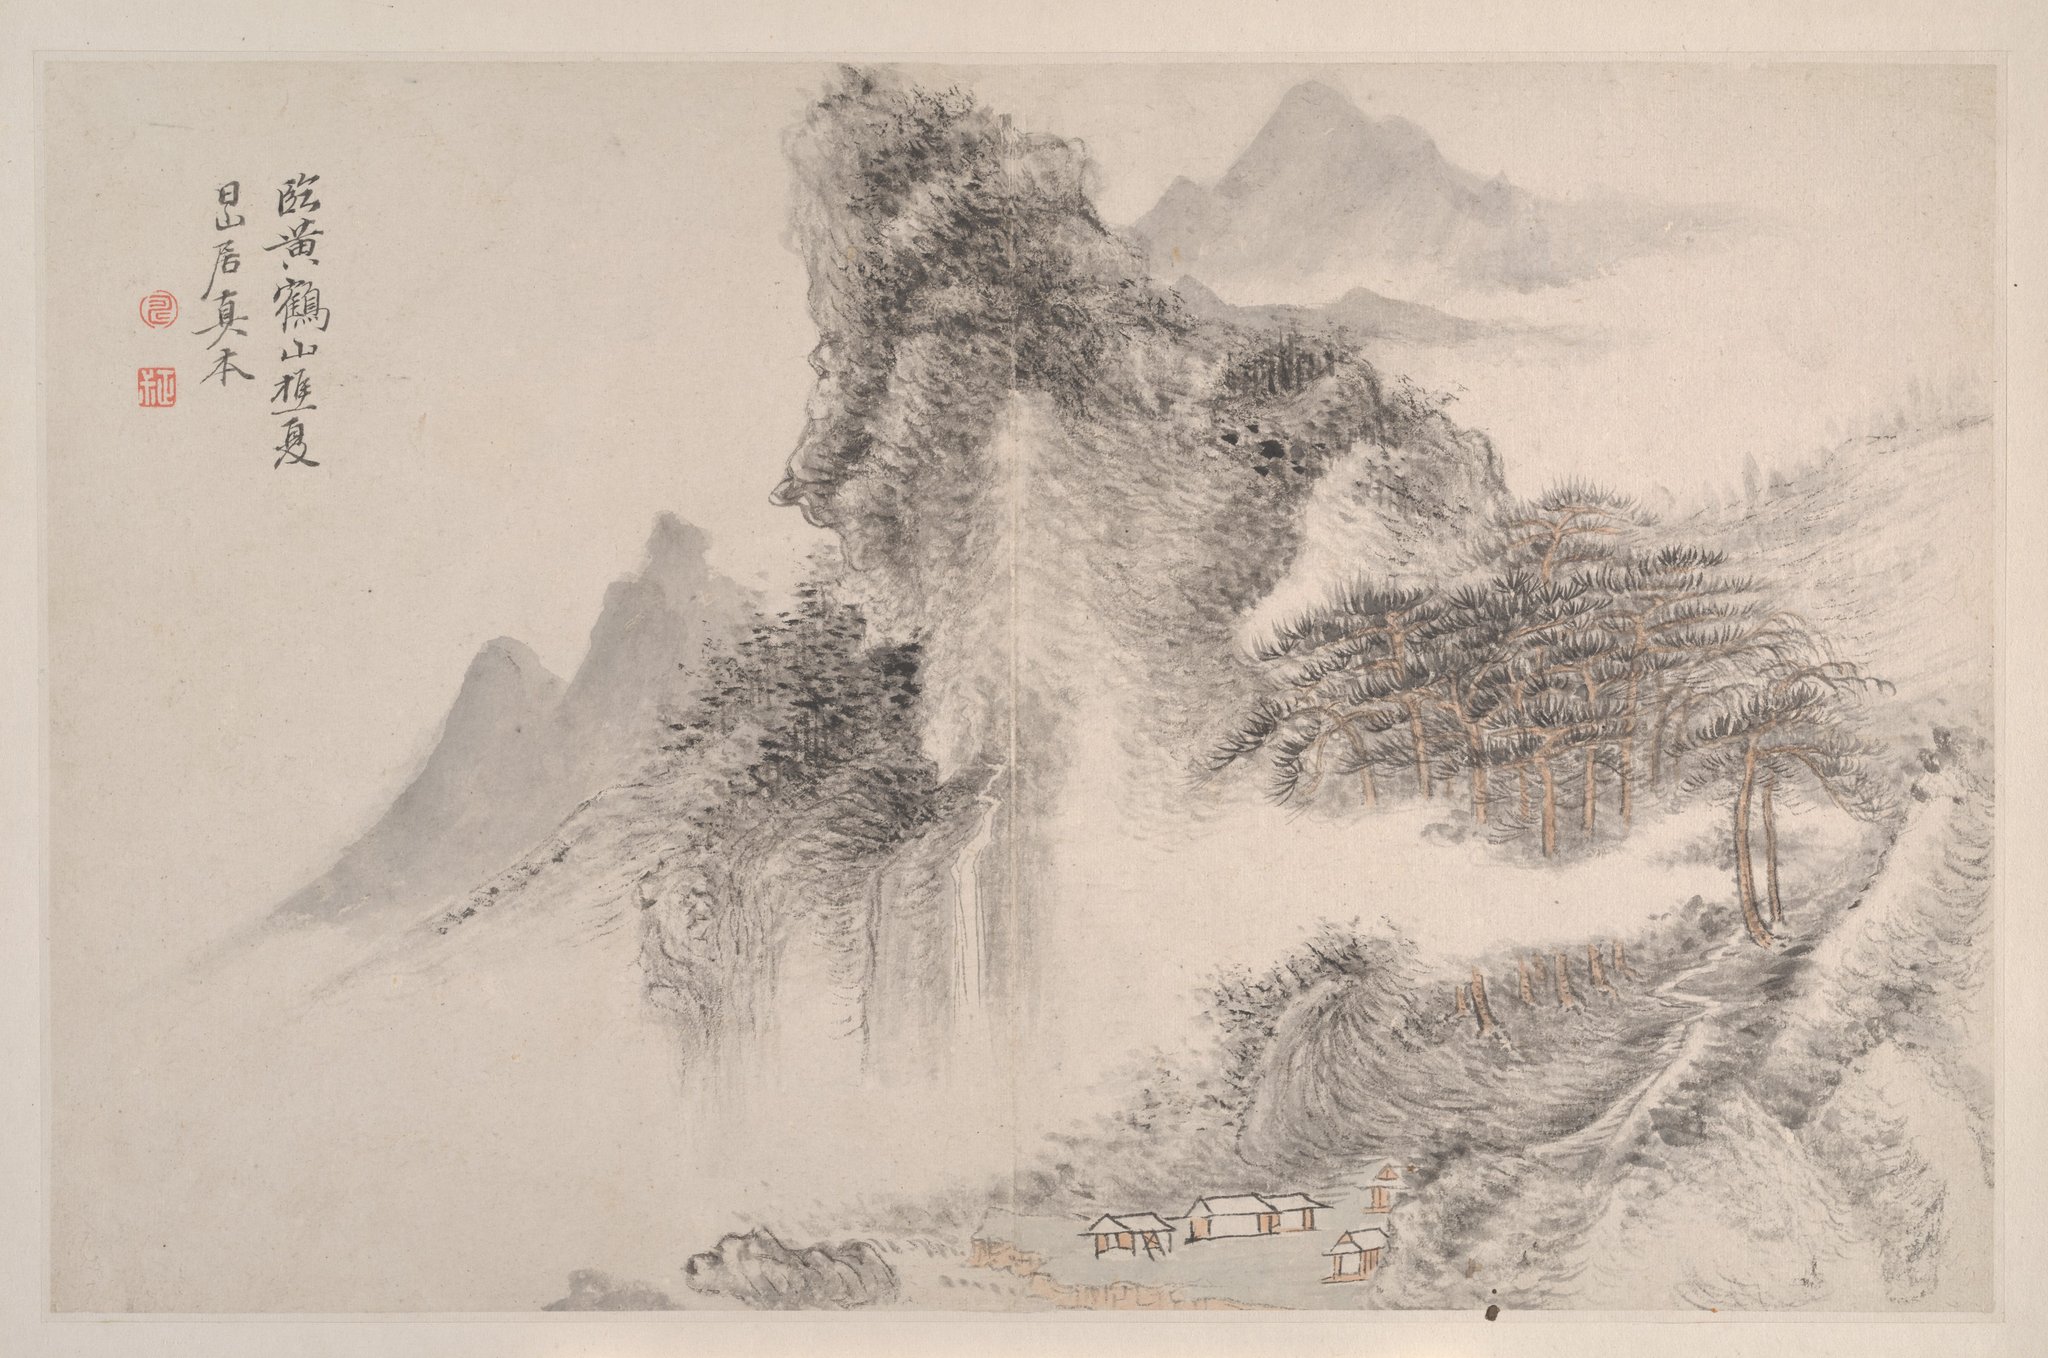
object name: album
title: Landscapes in the manner of Song and Yuan masters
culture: chinese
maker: yun shouping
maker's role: artist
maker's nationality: chinese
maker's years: 1633-1690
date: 1667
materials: ink, paper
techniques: painting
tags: mountains,landscapes